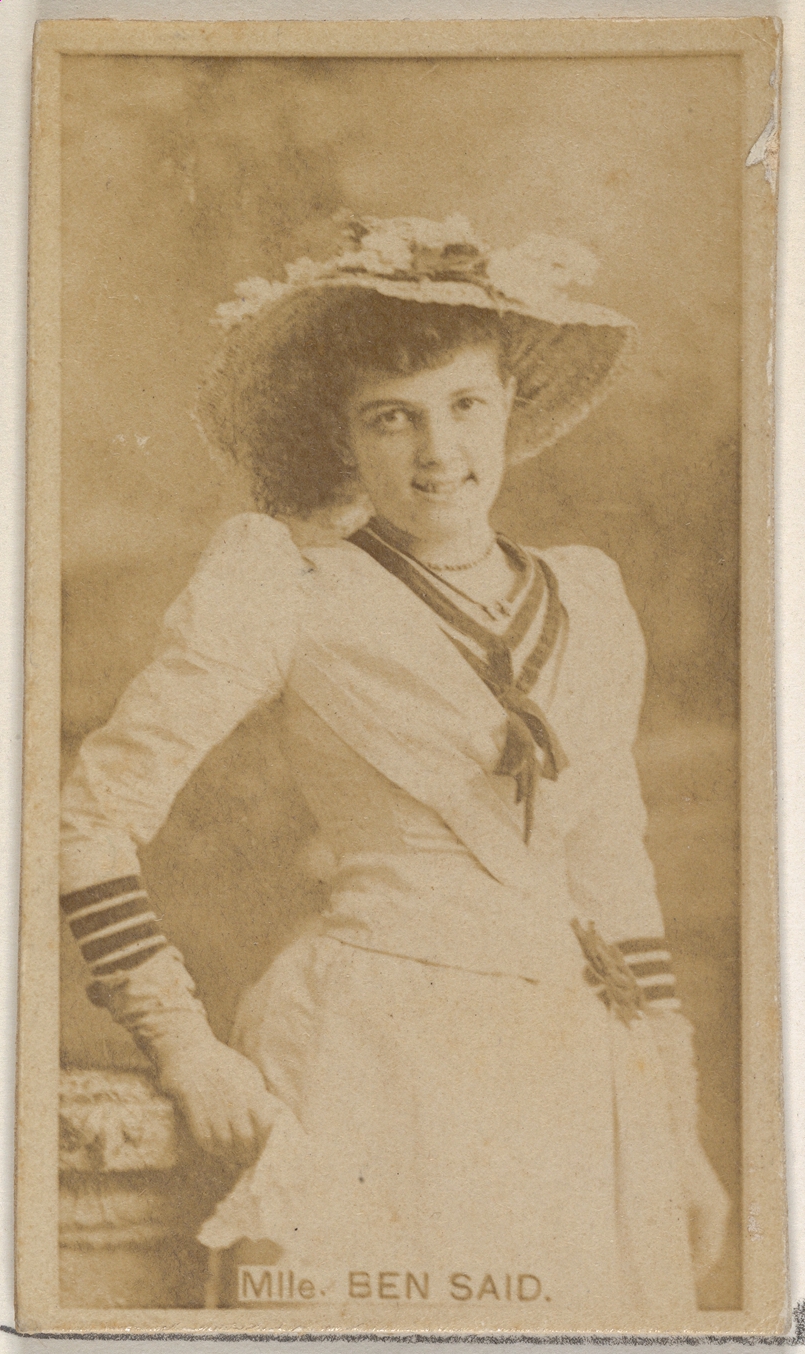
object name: photograph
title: Mlle. Ben Said, from the Actors and Actresses series (N45, Type 8) for Virginia Brights Cigarettes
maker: allen & ginter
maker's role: publisher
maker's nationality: american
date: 1888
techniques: albumen silver print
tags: portraits,women,actresses